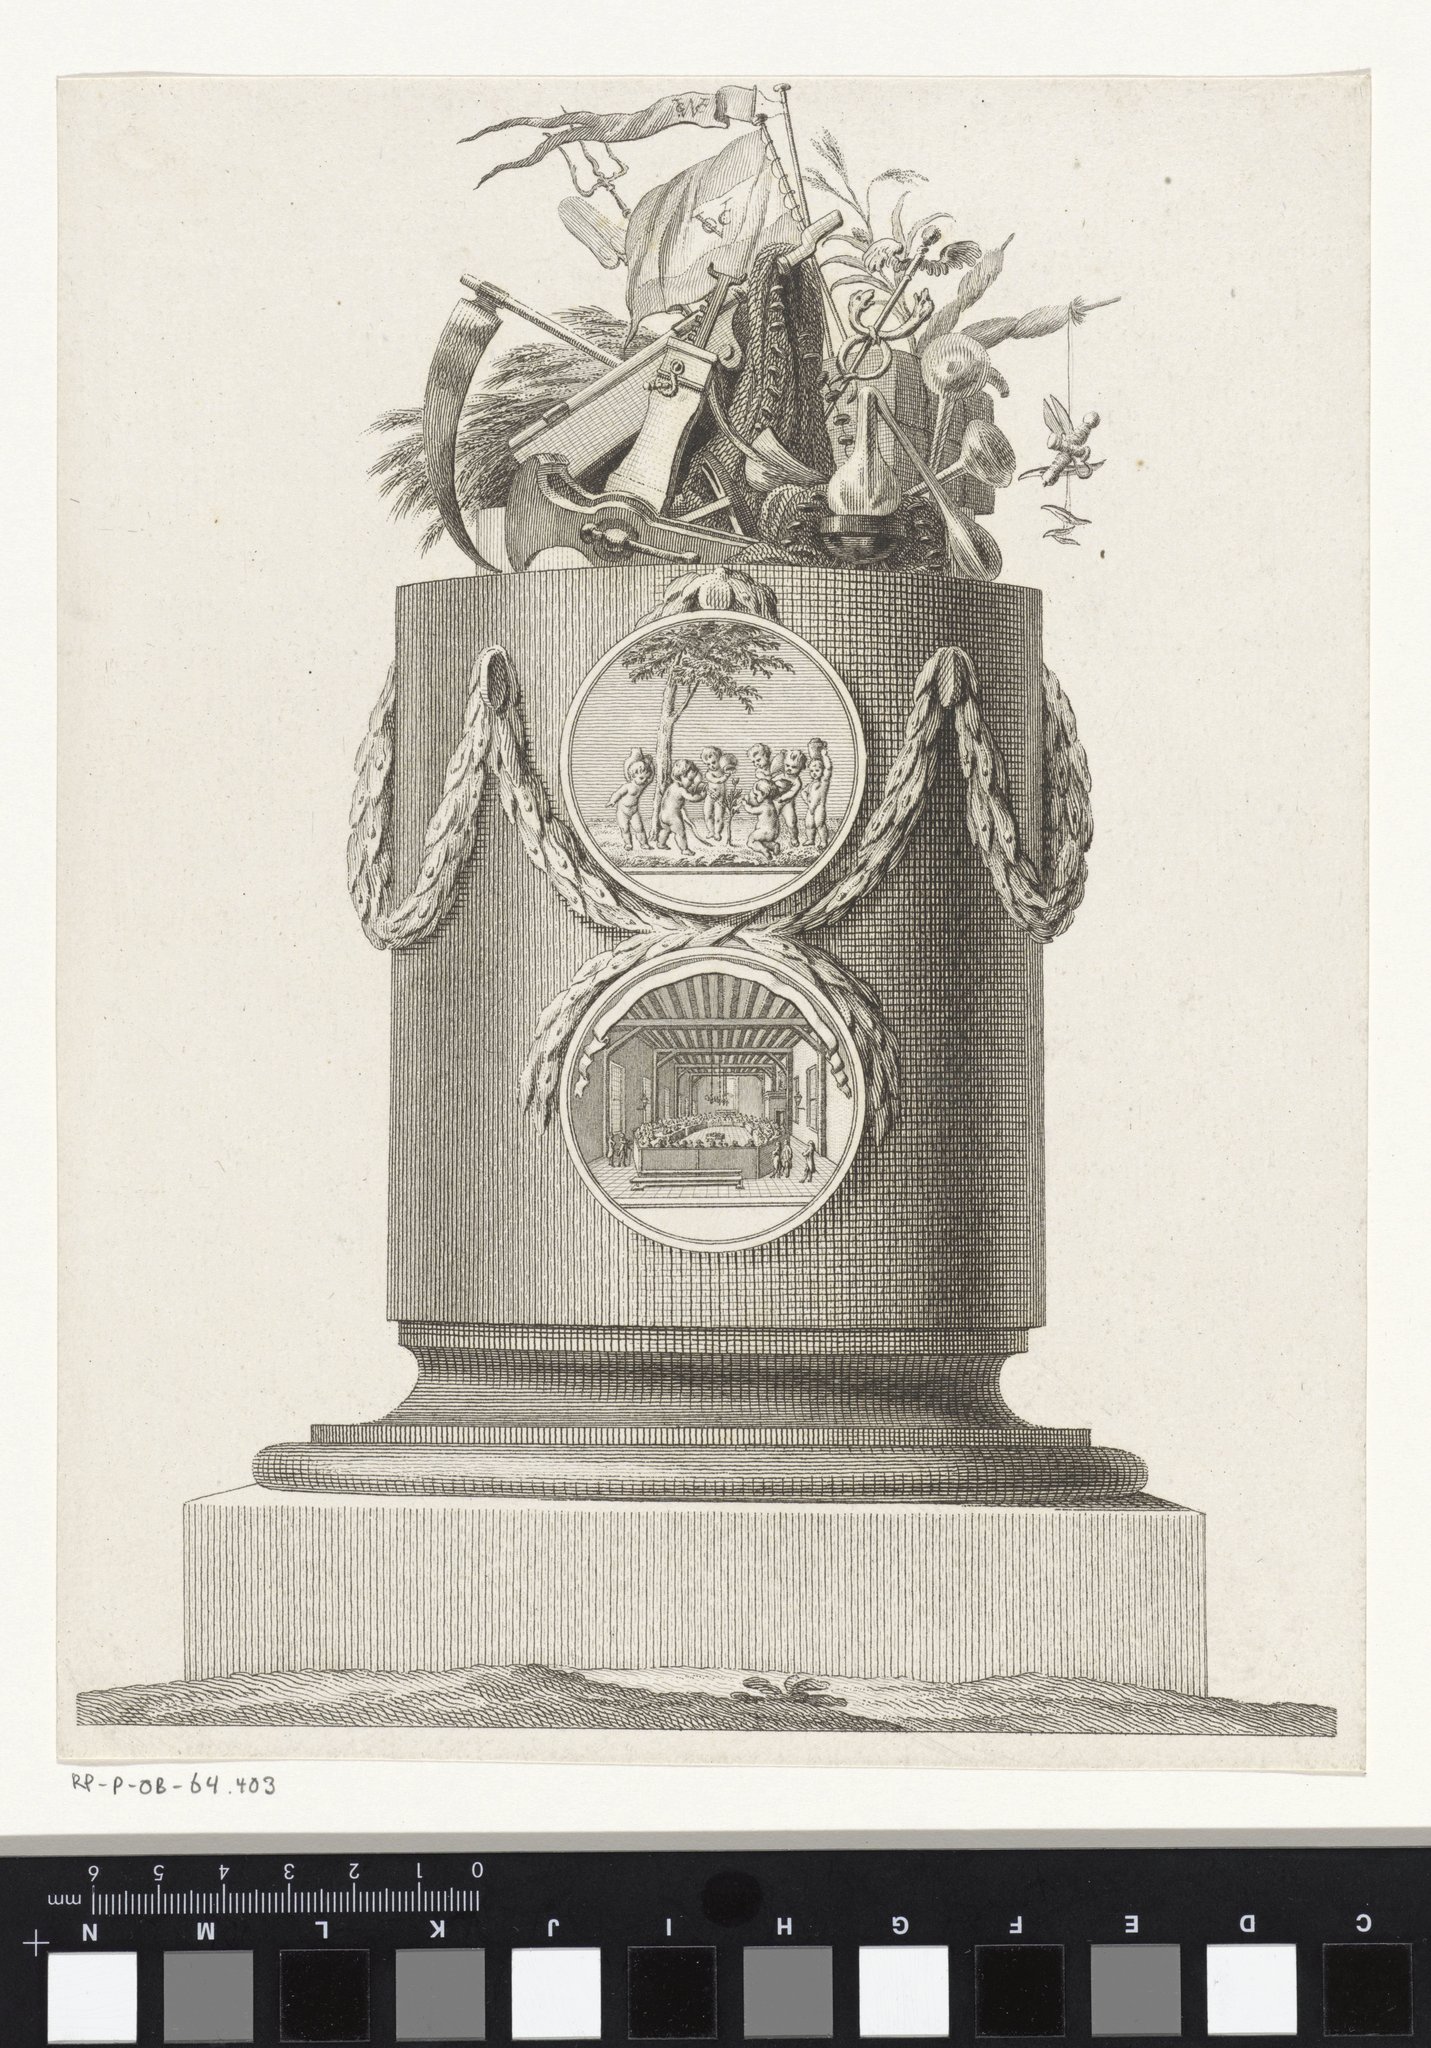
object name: print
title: Tijdvers op de algemene vergadering van de Oeconomische tak van de Maatschappij der Wetenschappen te Haarlem, 1778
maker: reinier vinkeles (i)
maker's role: draughtsman, print maker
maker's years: 1741-1816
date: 1778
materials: paper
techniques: engraving, etching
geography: amsterdam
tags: meeting, assembly, medal (considered as a piece of sculpture, regardless of its specific function)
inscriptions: collector's mark: Lugt 240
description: Zuil met voetstuk waarop een tijdvers op de algemene vergadering van de nieuwe Oeconomische tak van de Maatschappij der Wetenschappen te Haarlem, gehouden op 15 september 1778 in de zaal van het Diaconiehuis te Haarlem. Op de voorzijde van de zuil de penning geslagen ter gelegenheid van deze bijeenkomst, bovenop attributen van de beoefende wetenschappen.